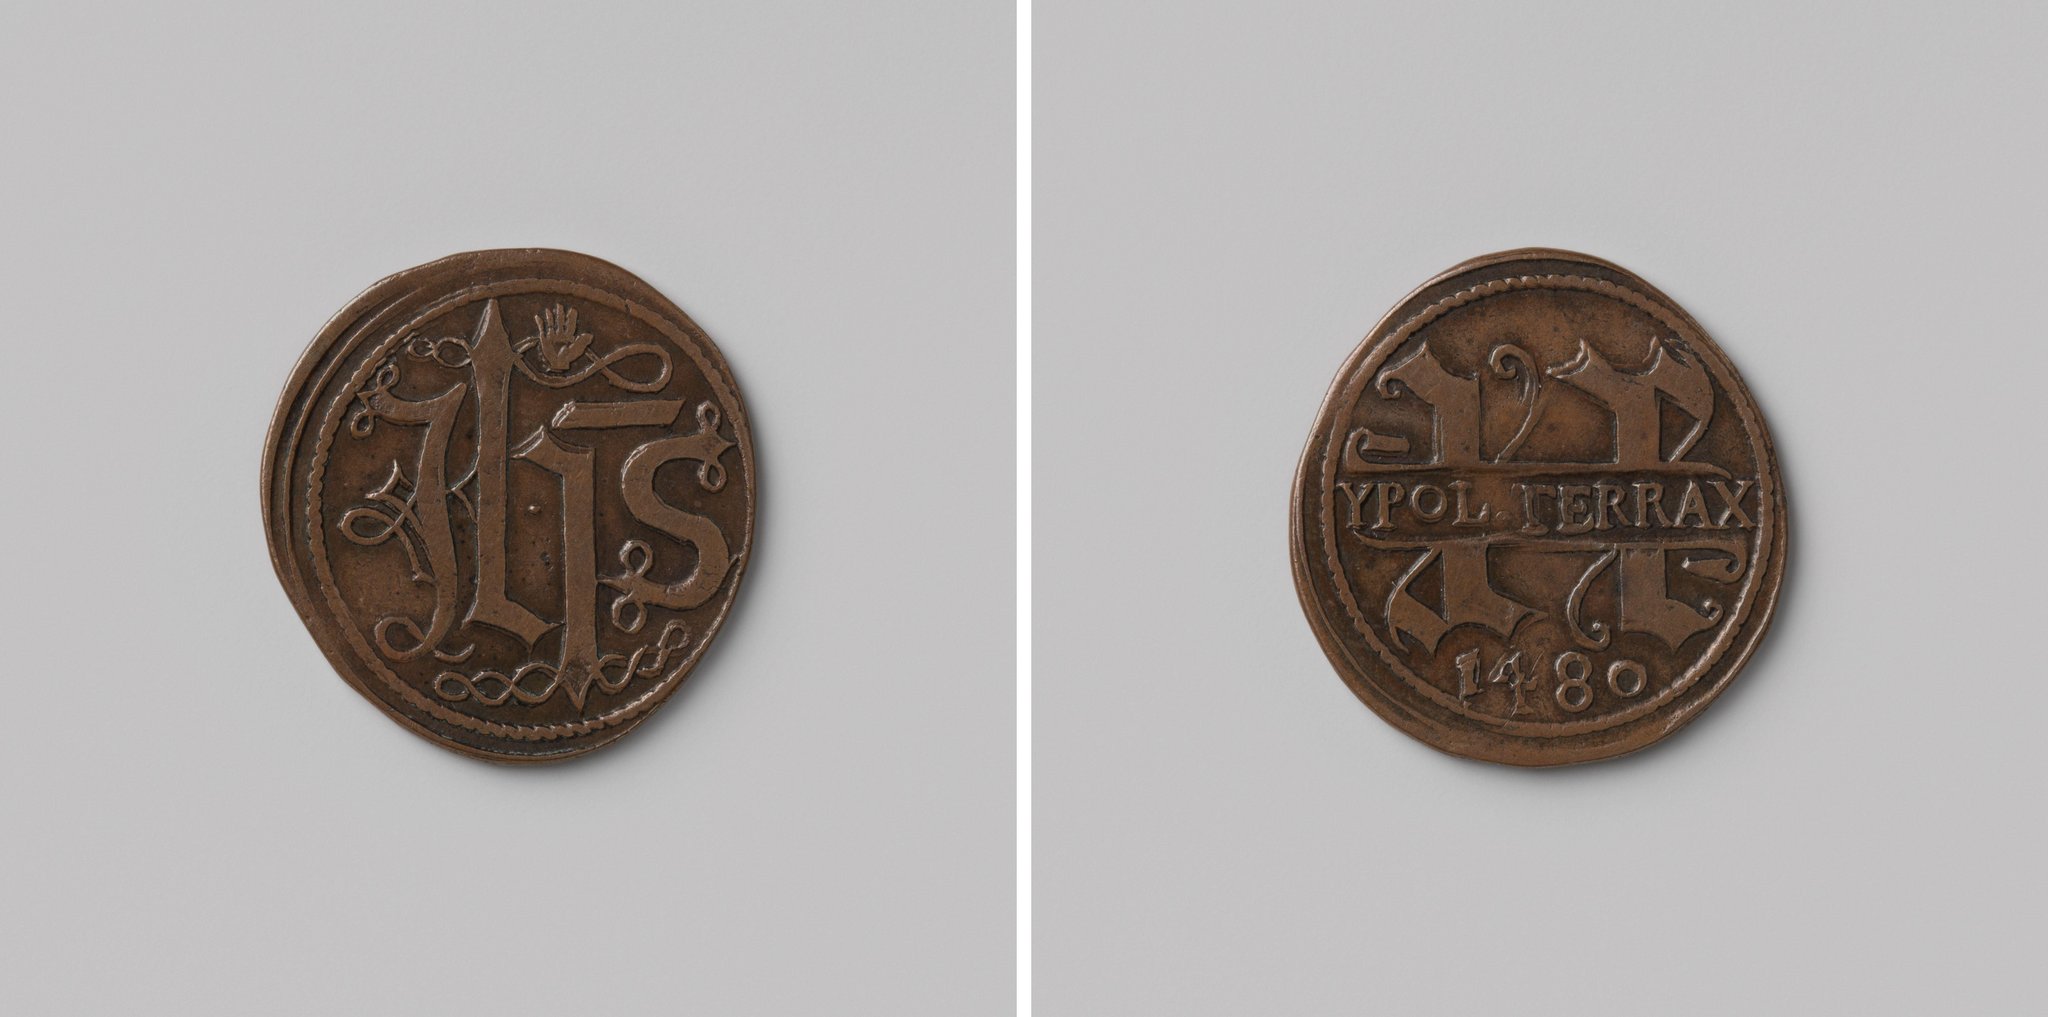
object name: jeton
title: Hippolyte Terrax, muntmeester aan de munt van Brabant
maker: Anonymous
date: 1480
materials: copper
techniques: striking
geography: antwerp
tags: antwerp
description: Koperen penning. Voorzijde: monogram van letters IHS onder geopende hand. Keerzijde: letter H; daarover een band met opschrift boven jaartal